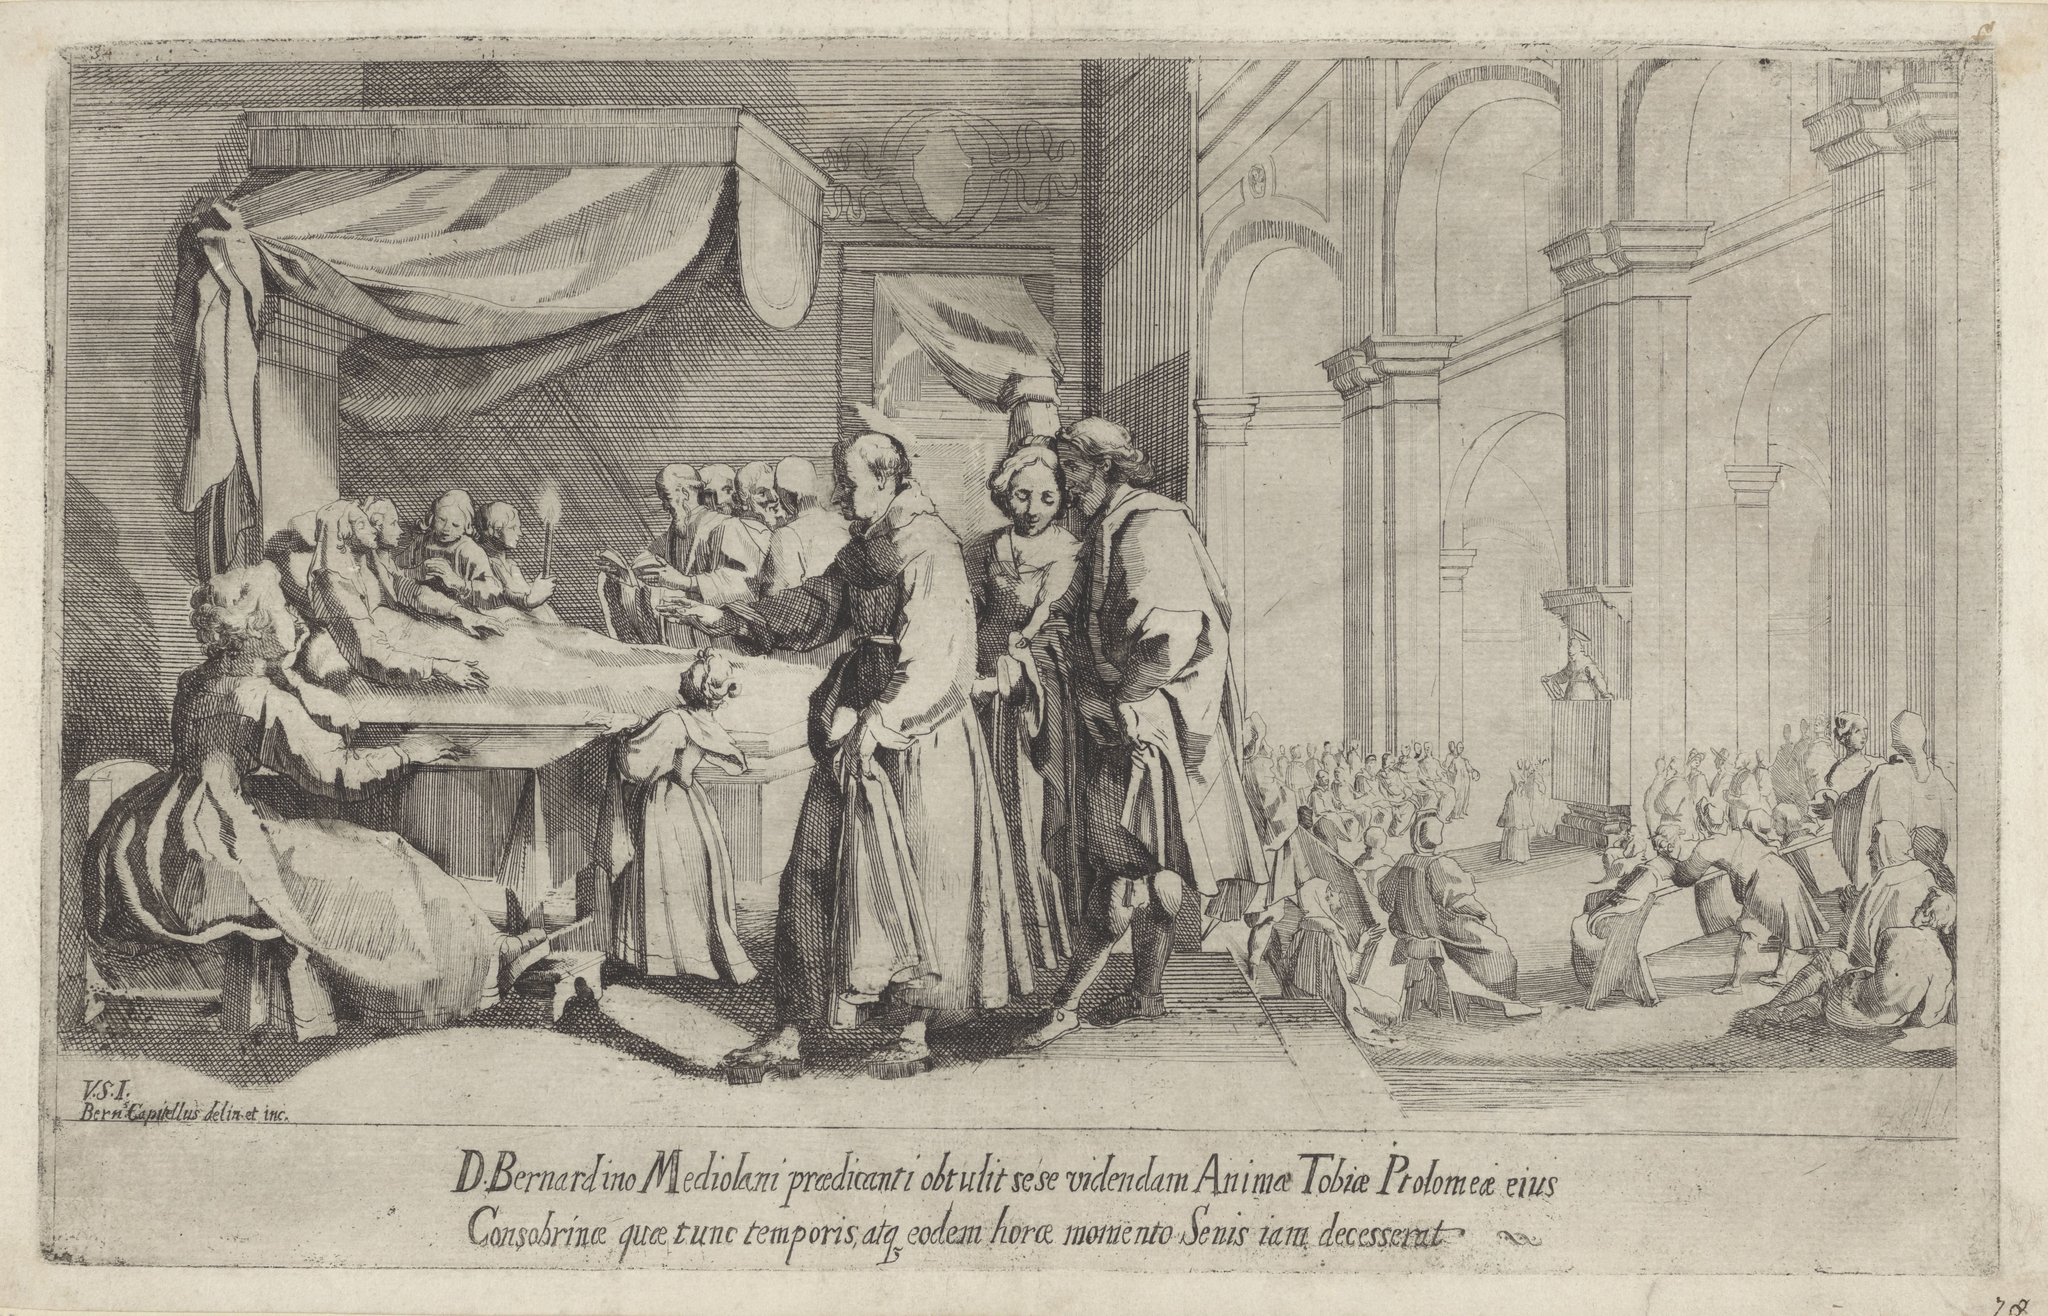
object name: print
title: De heilige Bernardinus van Siena brengt een kind tot leven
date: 1599-1640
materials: paper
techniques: etching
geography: siena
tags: bernardino of siena, franciscan friar; possible attributes: book, tablet (disk) with ihs monogram, three mitres at his feet - miraculous activities and events ~ male saint, bernardino of siena, franciscan friar; possible attributes: book, tablet (disk) with ihs monogram, three mitres at his feet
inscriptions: collector's mark: Lugt 240, number: ‘78’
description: Links zicht in een slaapkamer met een overleden meisje in bed, Tobia Tolomesi, de nicht van de heilige Bernardinus van Siena. Rondom het bed staan familie en geestelijken. Aan het voeteneinde staat de heilige Bernardinus van Siena die het meisje weer tot leven wekt. Rechts zicht in een kerk waar de heilige Bernardinus van Siena preekt voor een menigte gelovigen. Tekst in ondermarge